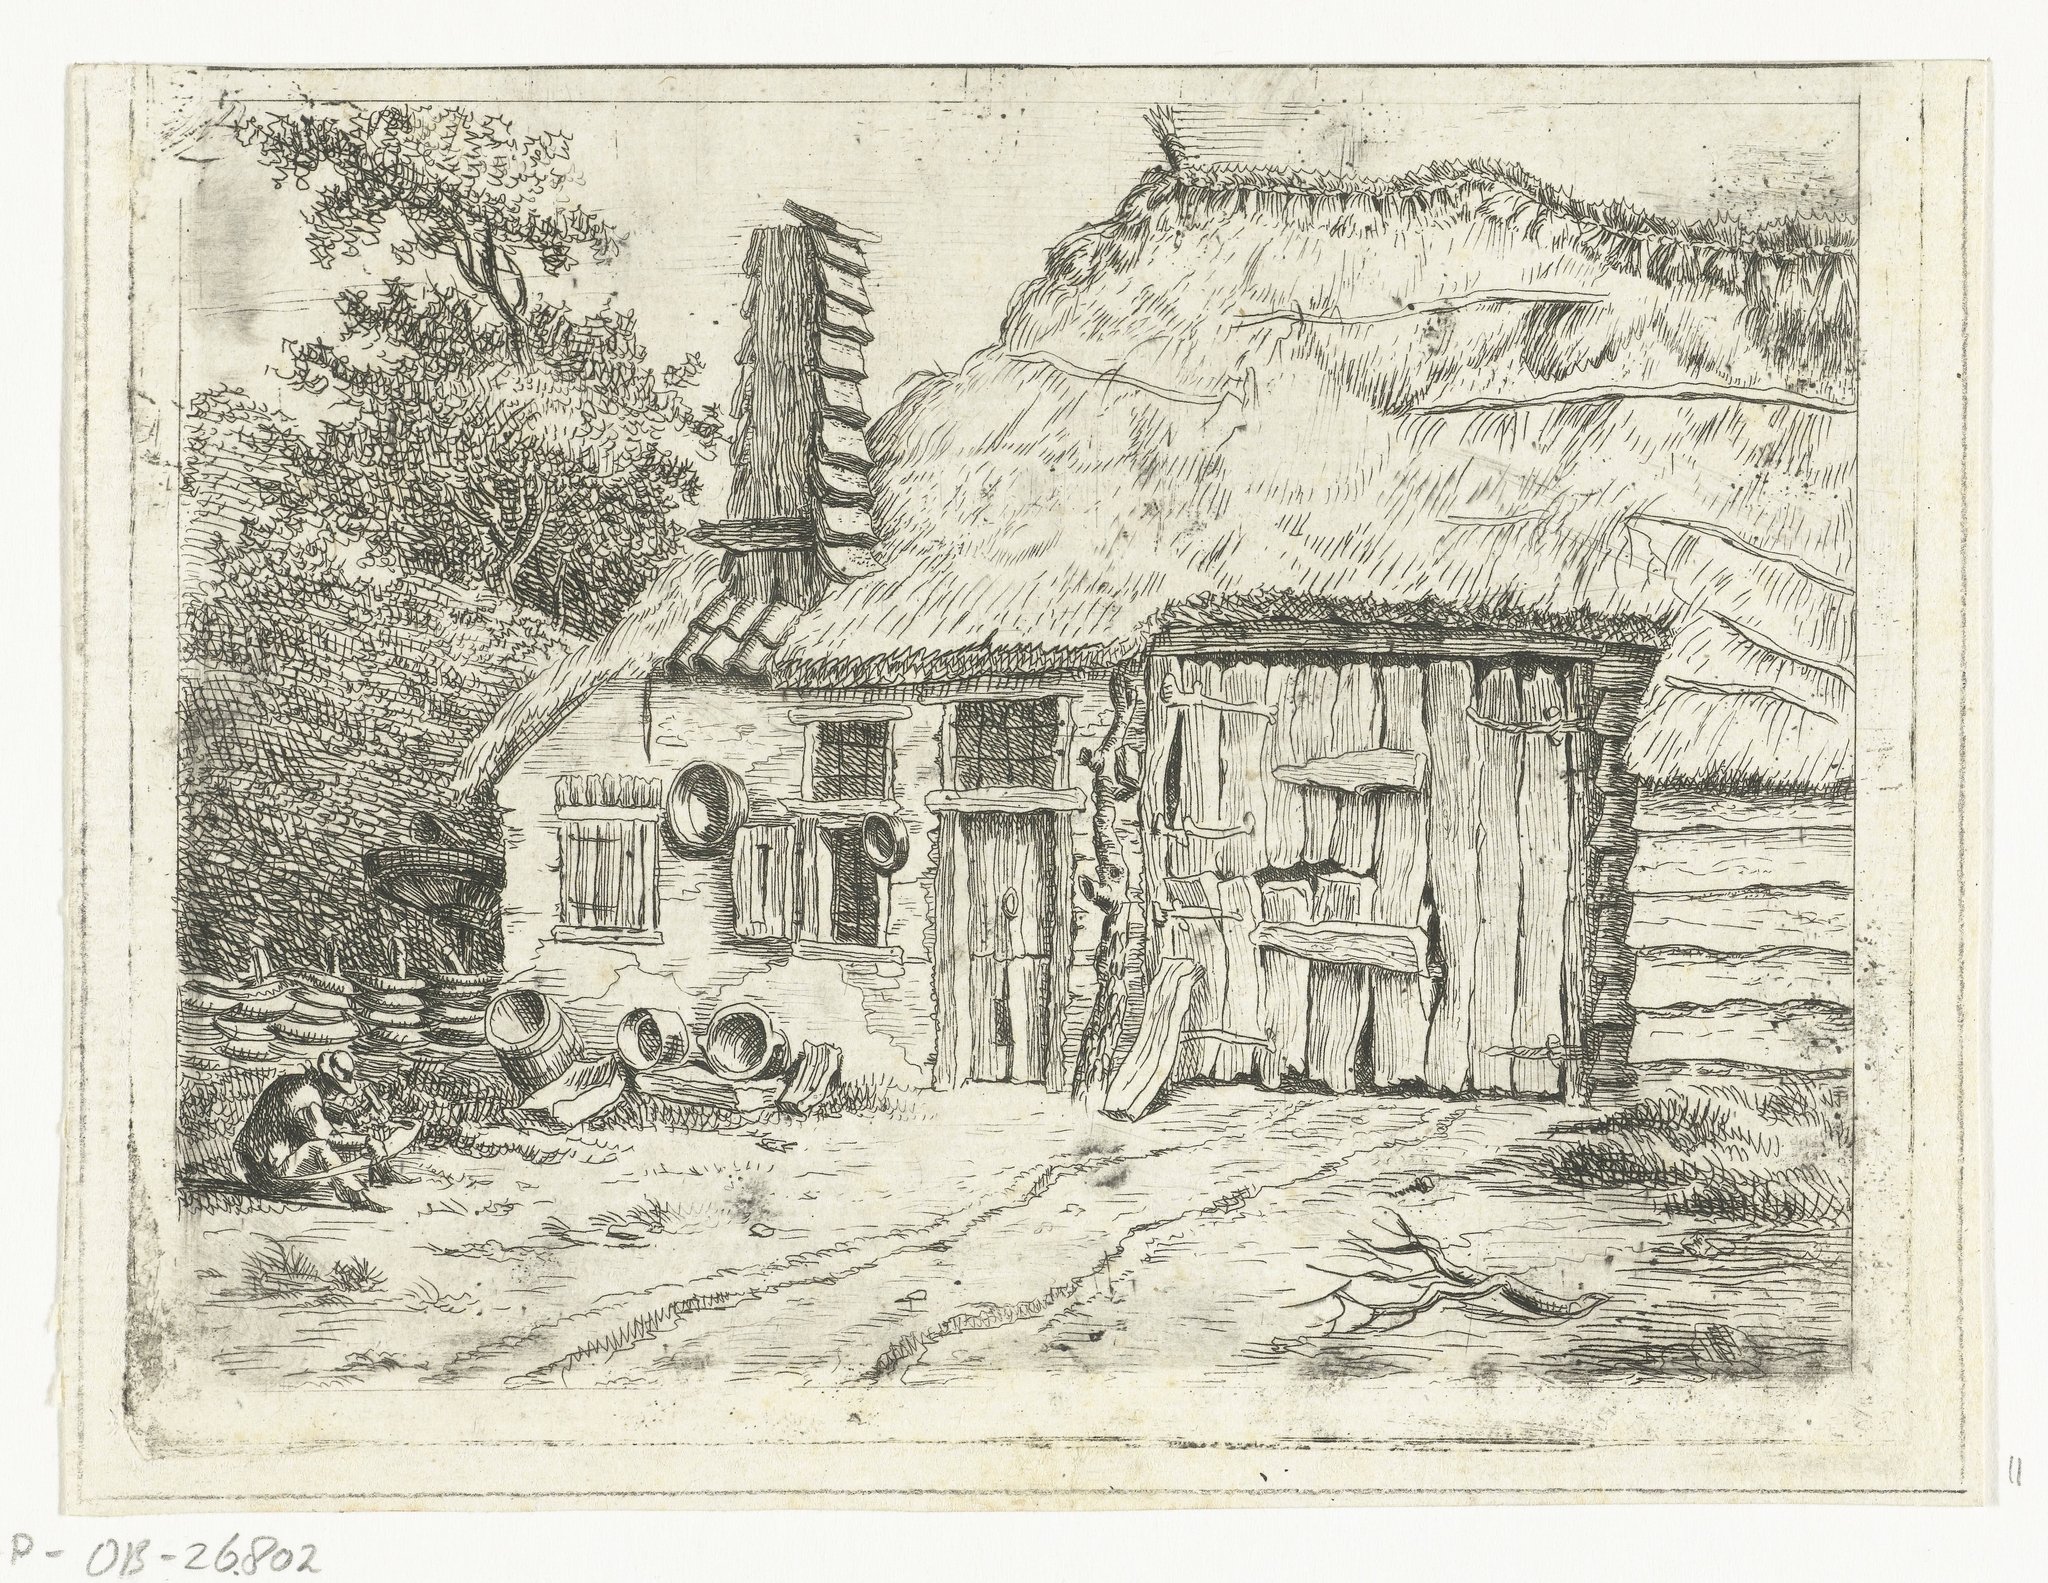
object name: print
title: In het land Drenthe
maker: anthonie van den bos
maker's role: draughtsman, print maker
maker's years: 1763-1838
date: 1778-1838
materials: paper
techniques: etching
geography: netherlands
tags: agricultural implements: scythe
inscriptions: collector's mark: Lugt 2228